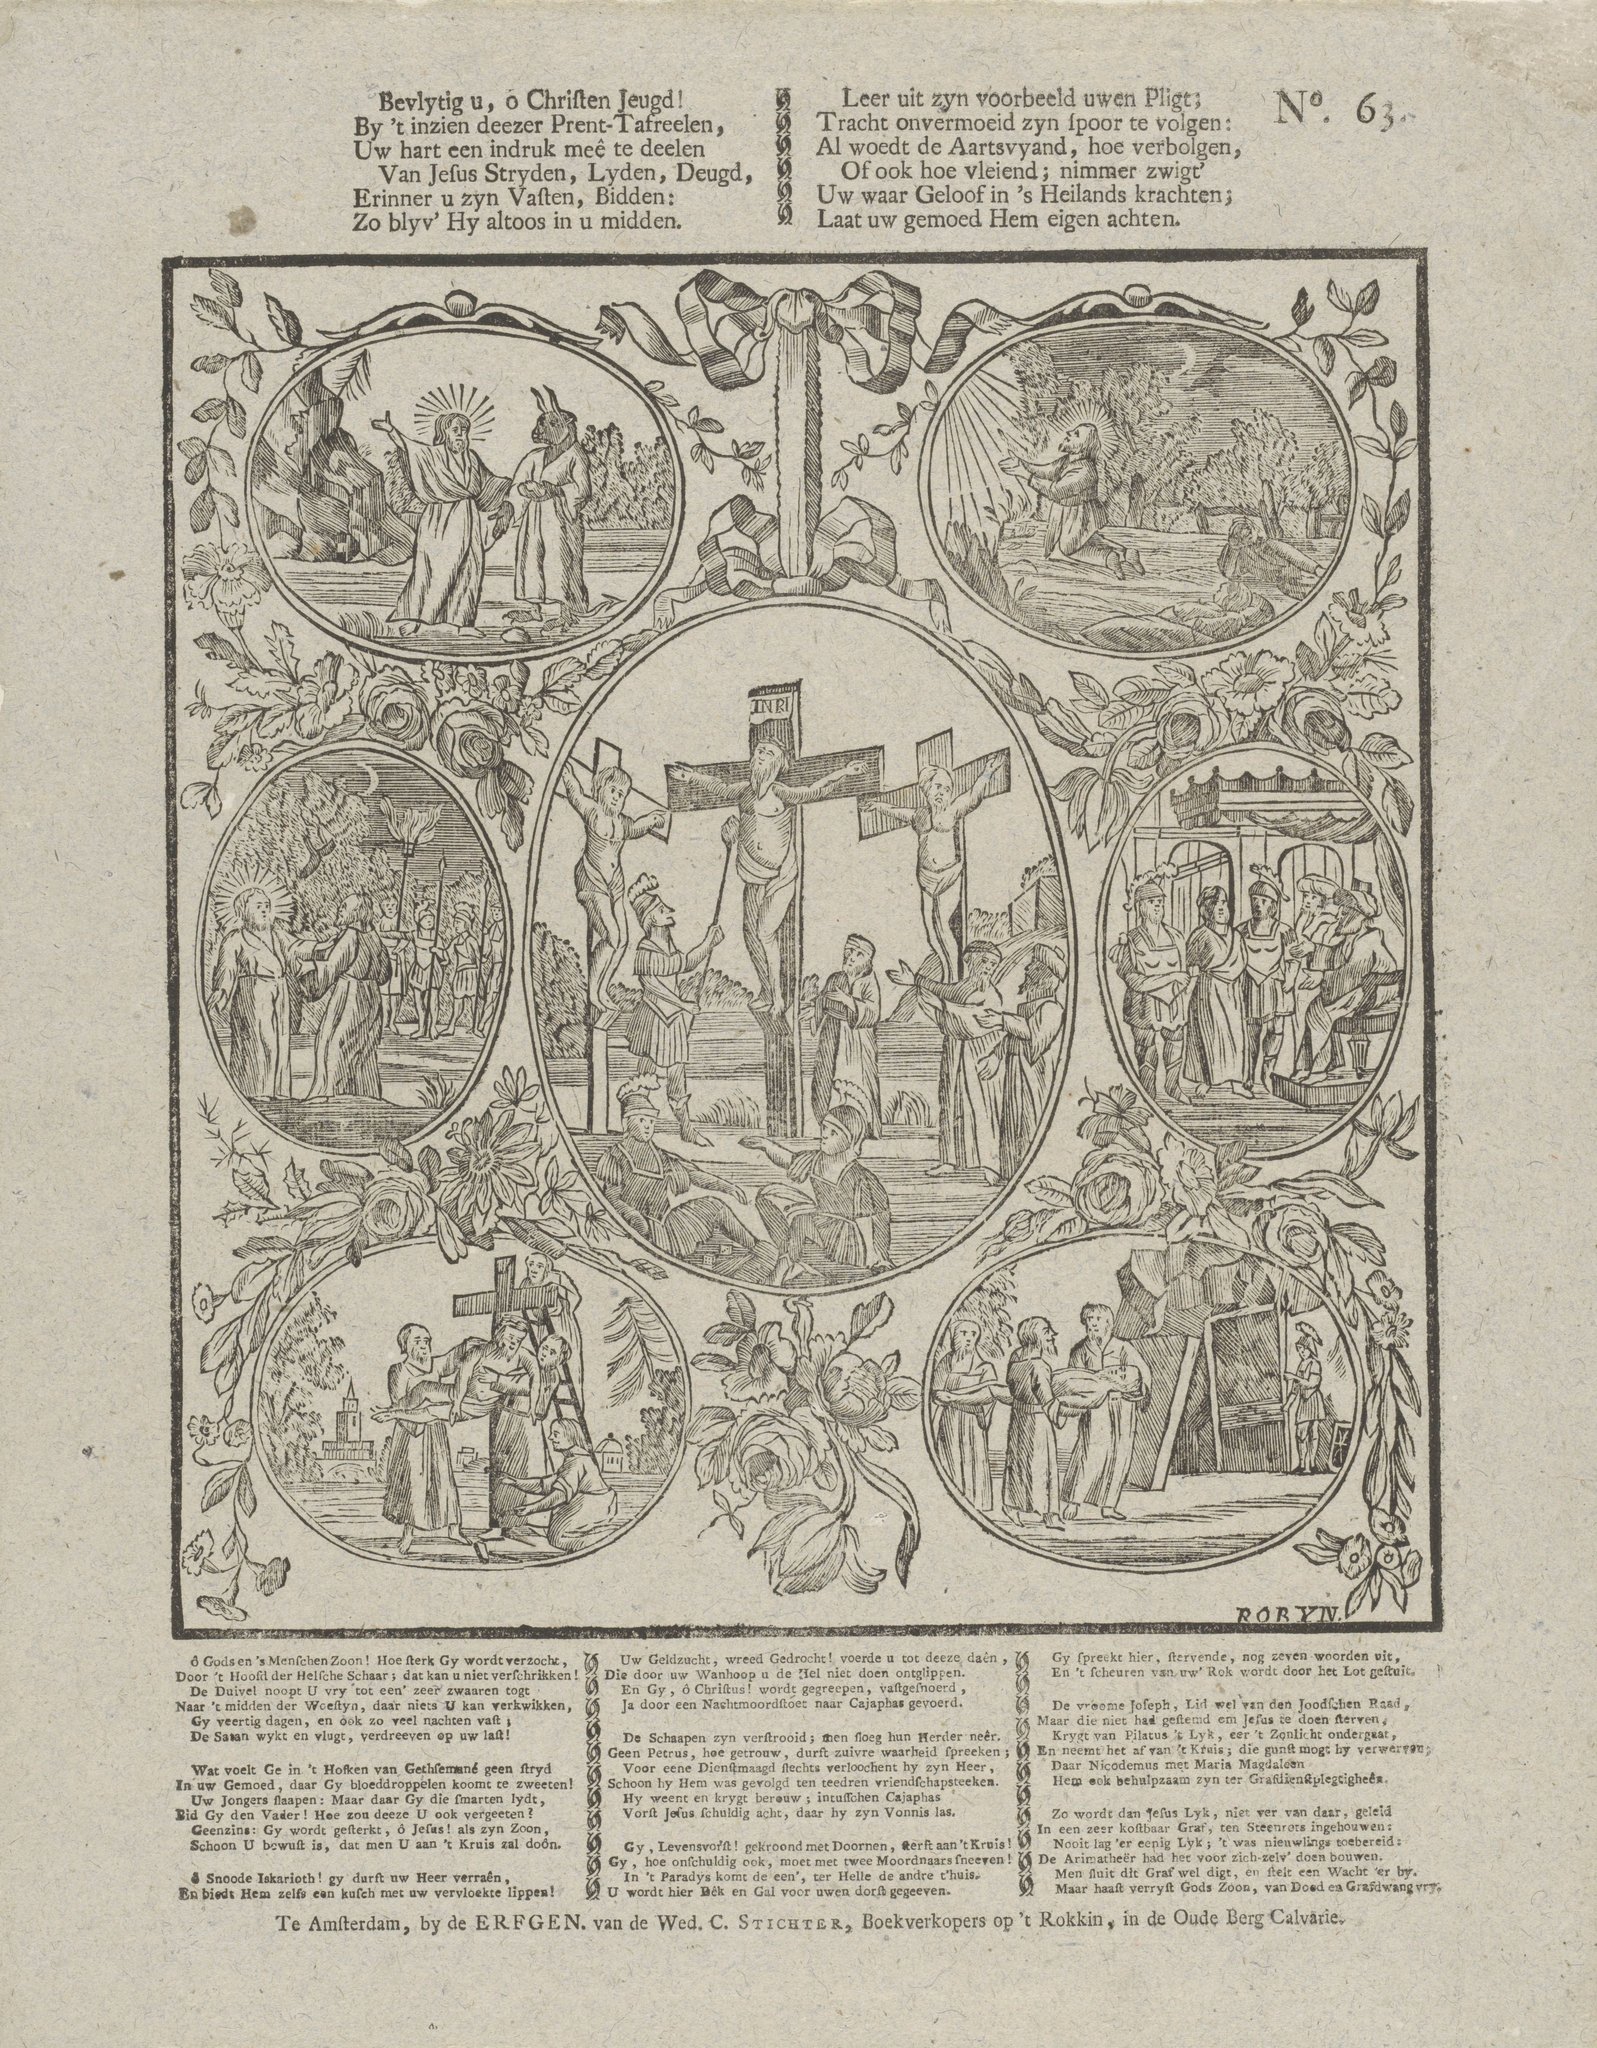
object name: print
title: Bevlytig u, o Christen jeugd! / By 't inzien deezer prent-tafreelen [(...)]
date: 1715-1813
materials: paper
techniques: letterpress printing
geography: amsterdam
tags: new testament, series of scenes from the life of christ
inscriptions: collector's mark: Lugt 2760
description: Blad met 7 medaillons met scènes uit het leven van Christus, zoals de Kruisiging van Christus en de Kruisafname. De voorstellingen zijn aan elkaar verbonden met linten en bloemenranken. Het geheel is gevat in een kader. Onder de afbeelding een vers in drie kolommen. Genummerd rechtsboven: No. 63.